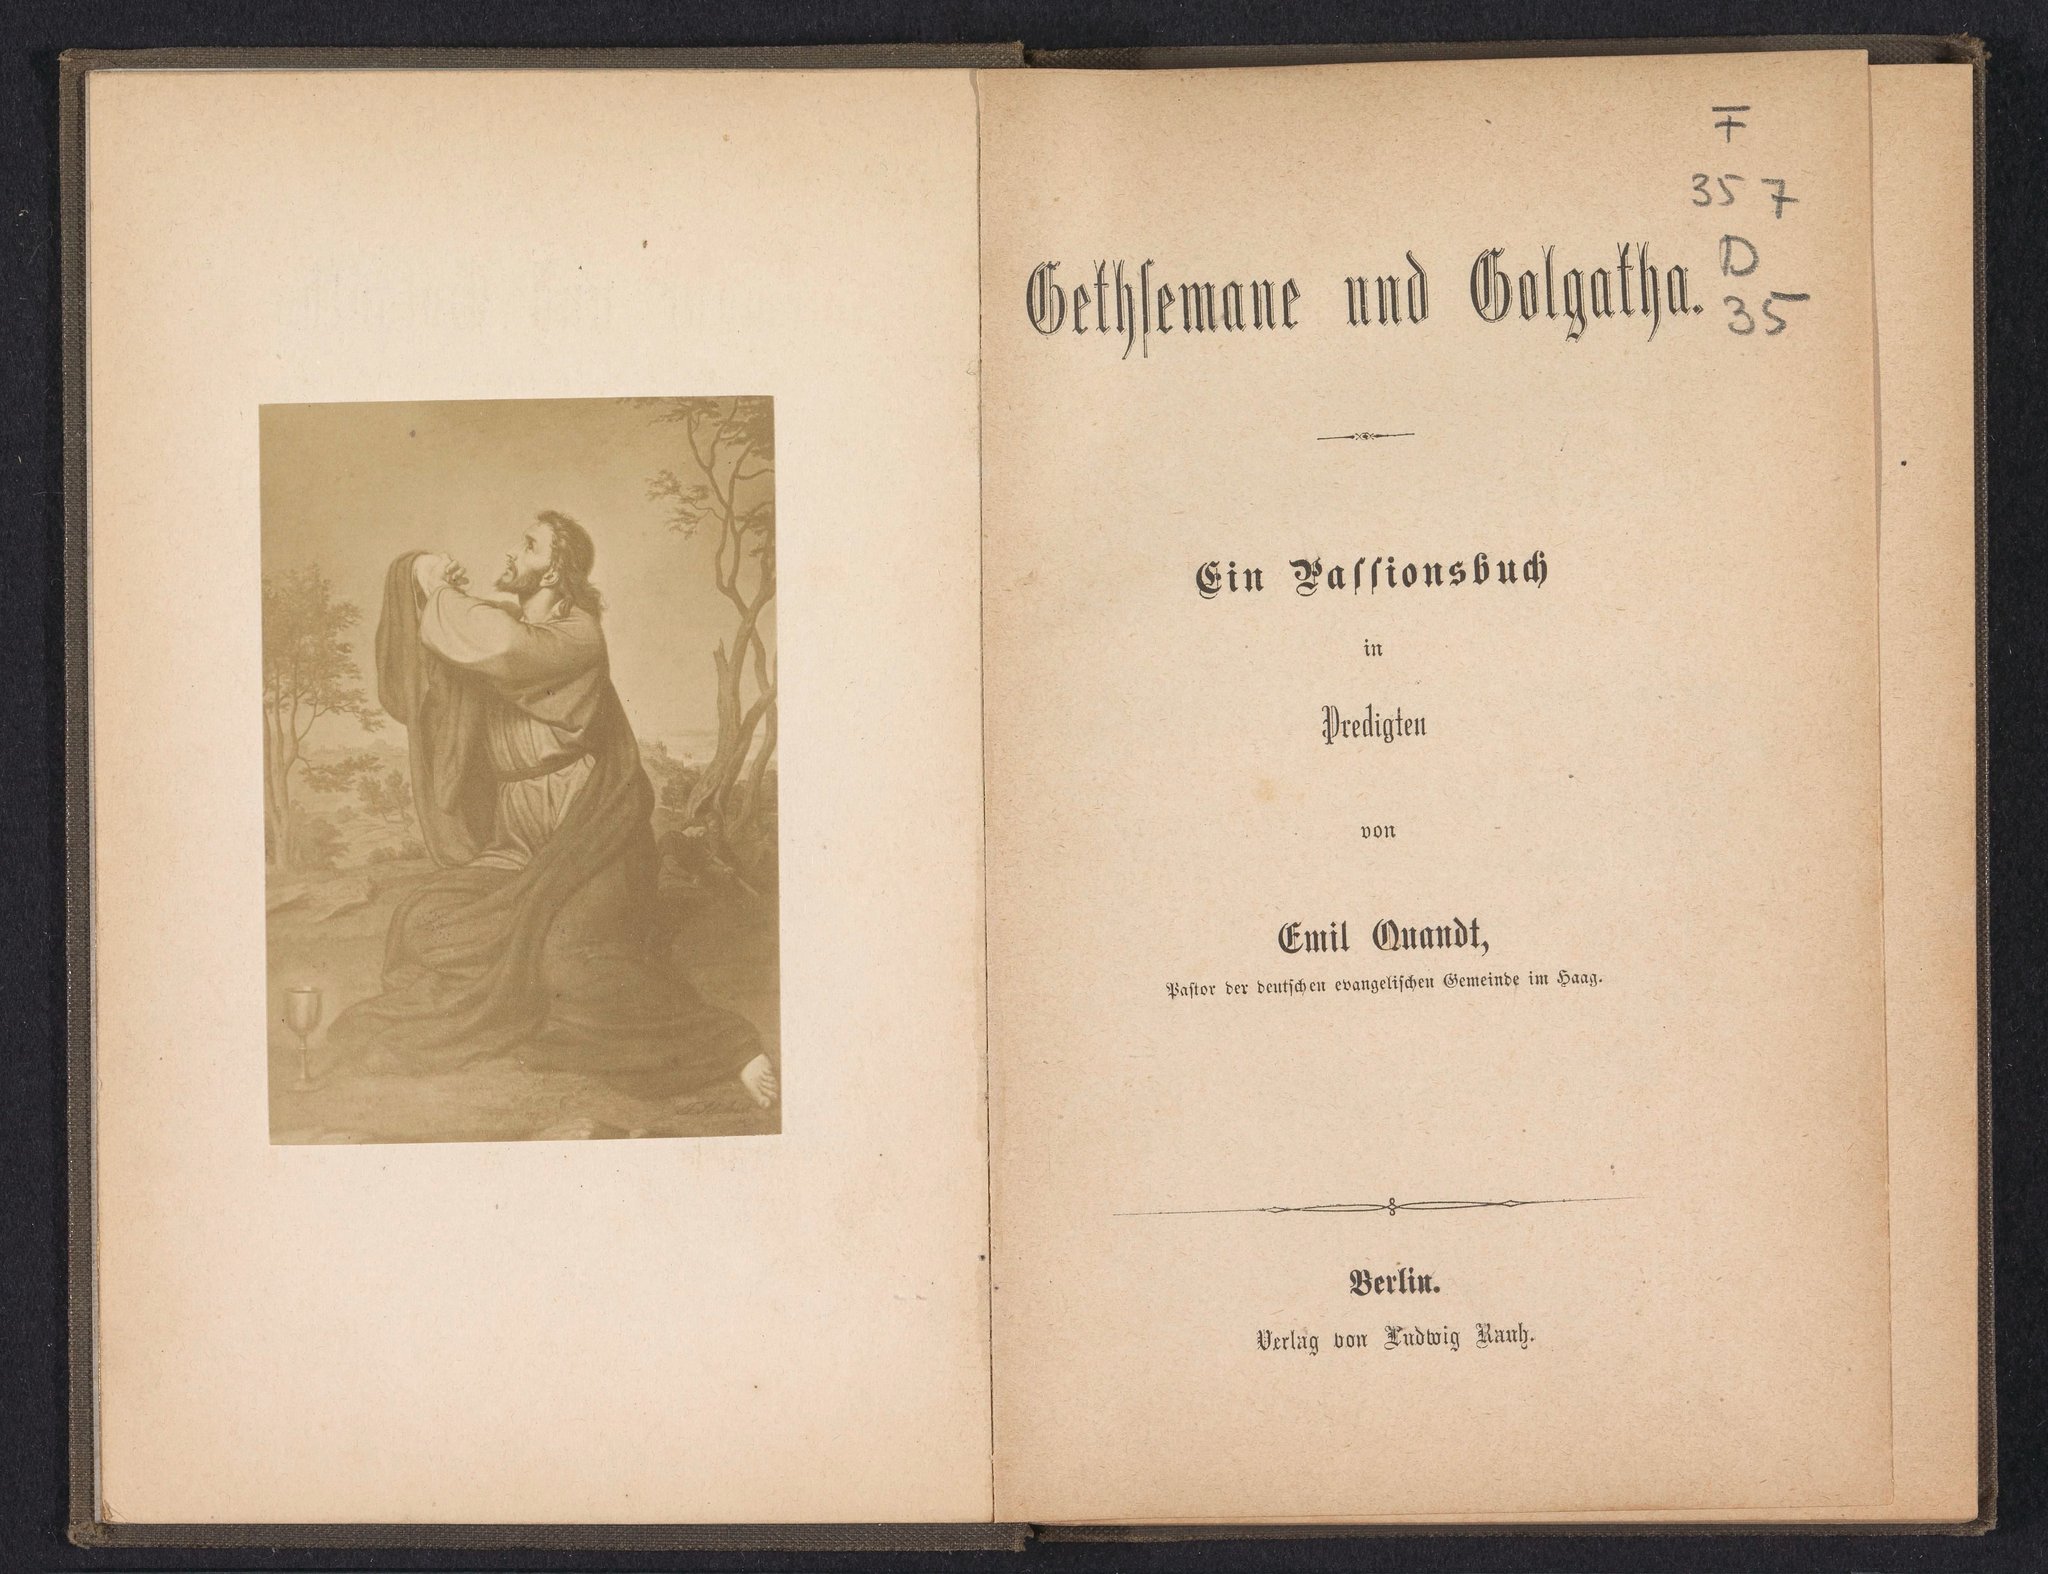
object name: book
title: Gethsemane und Golgotha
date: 1873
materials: cardboard, linen, paper, photographic support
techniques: albumen print, printing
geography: berlin